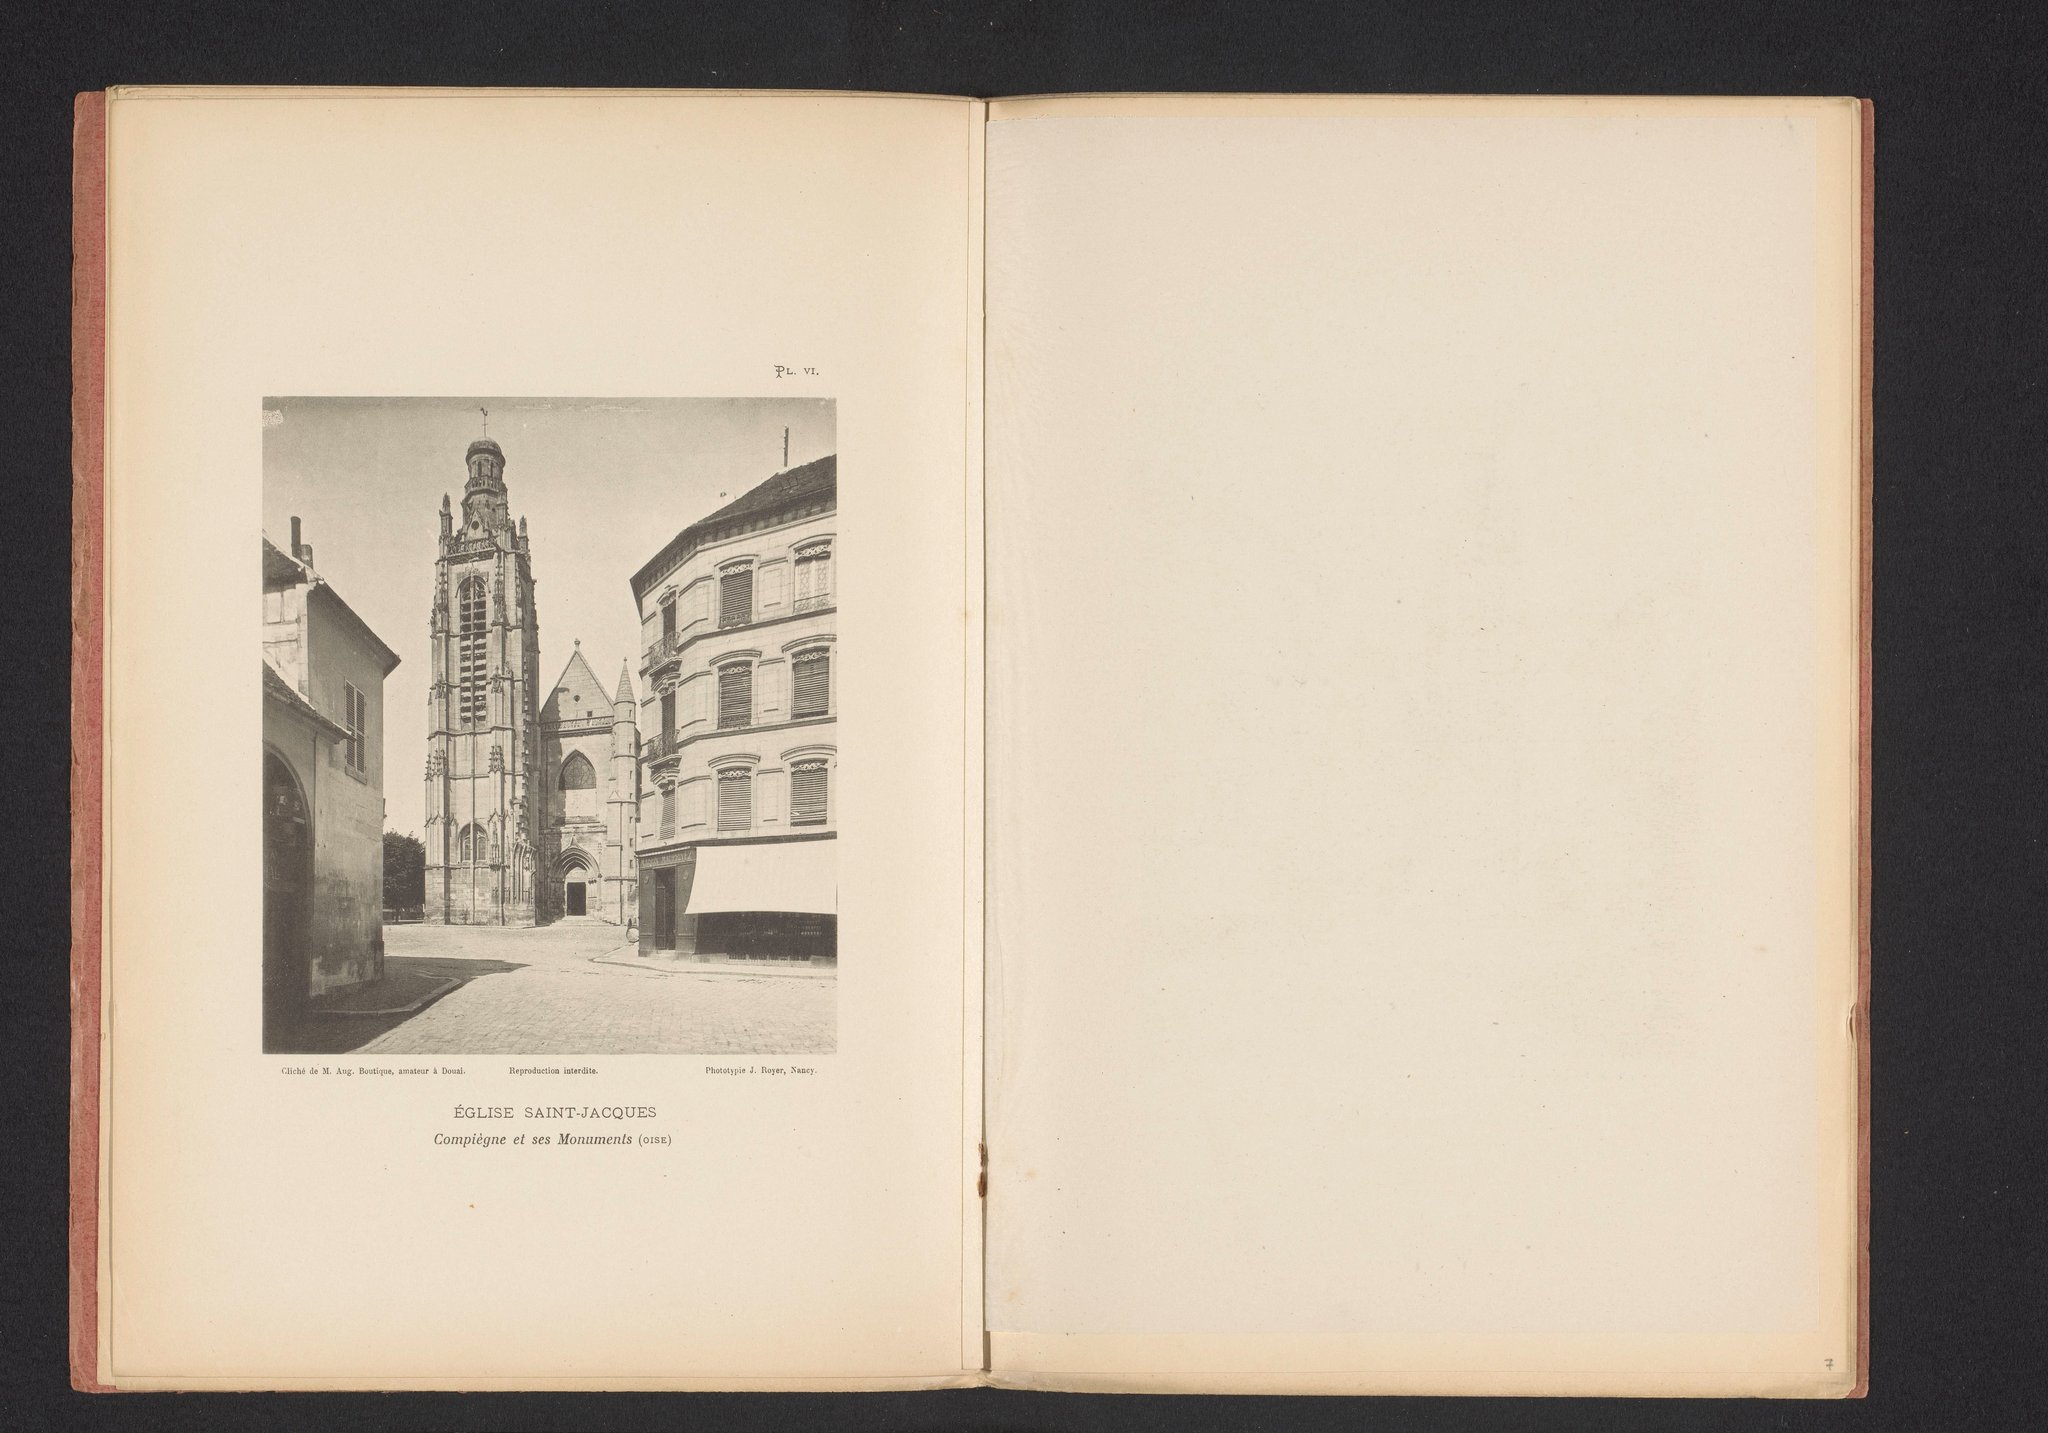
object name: photomechanical print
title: Compiègne et ses Monuments (oise)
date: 1890-1895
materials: paper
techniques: photograph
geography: douai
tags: church (exterior)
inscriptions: inscription: ‘Reproduction interdite.’, number: ‘Pl. VI.’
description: Prent op zesde ongenummerde pagina na pagina 4.